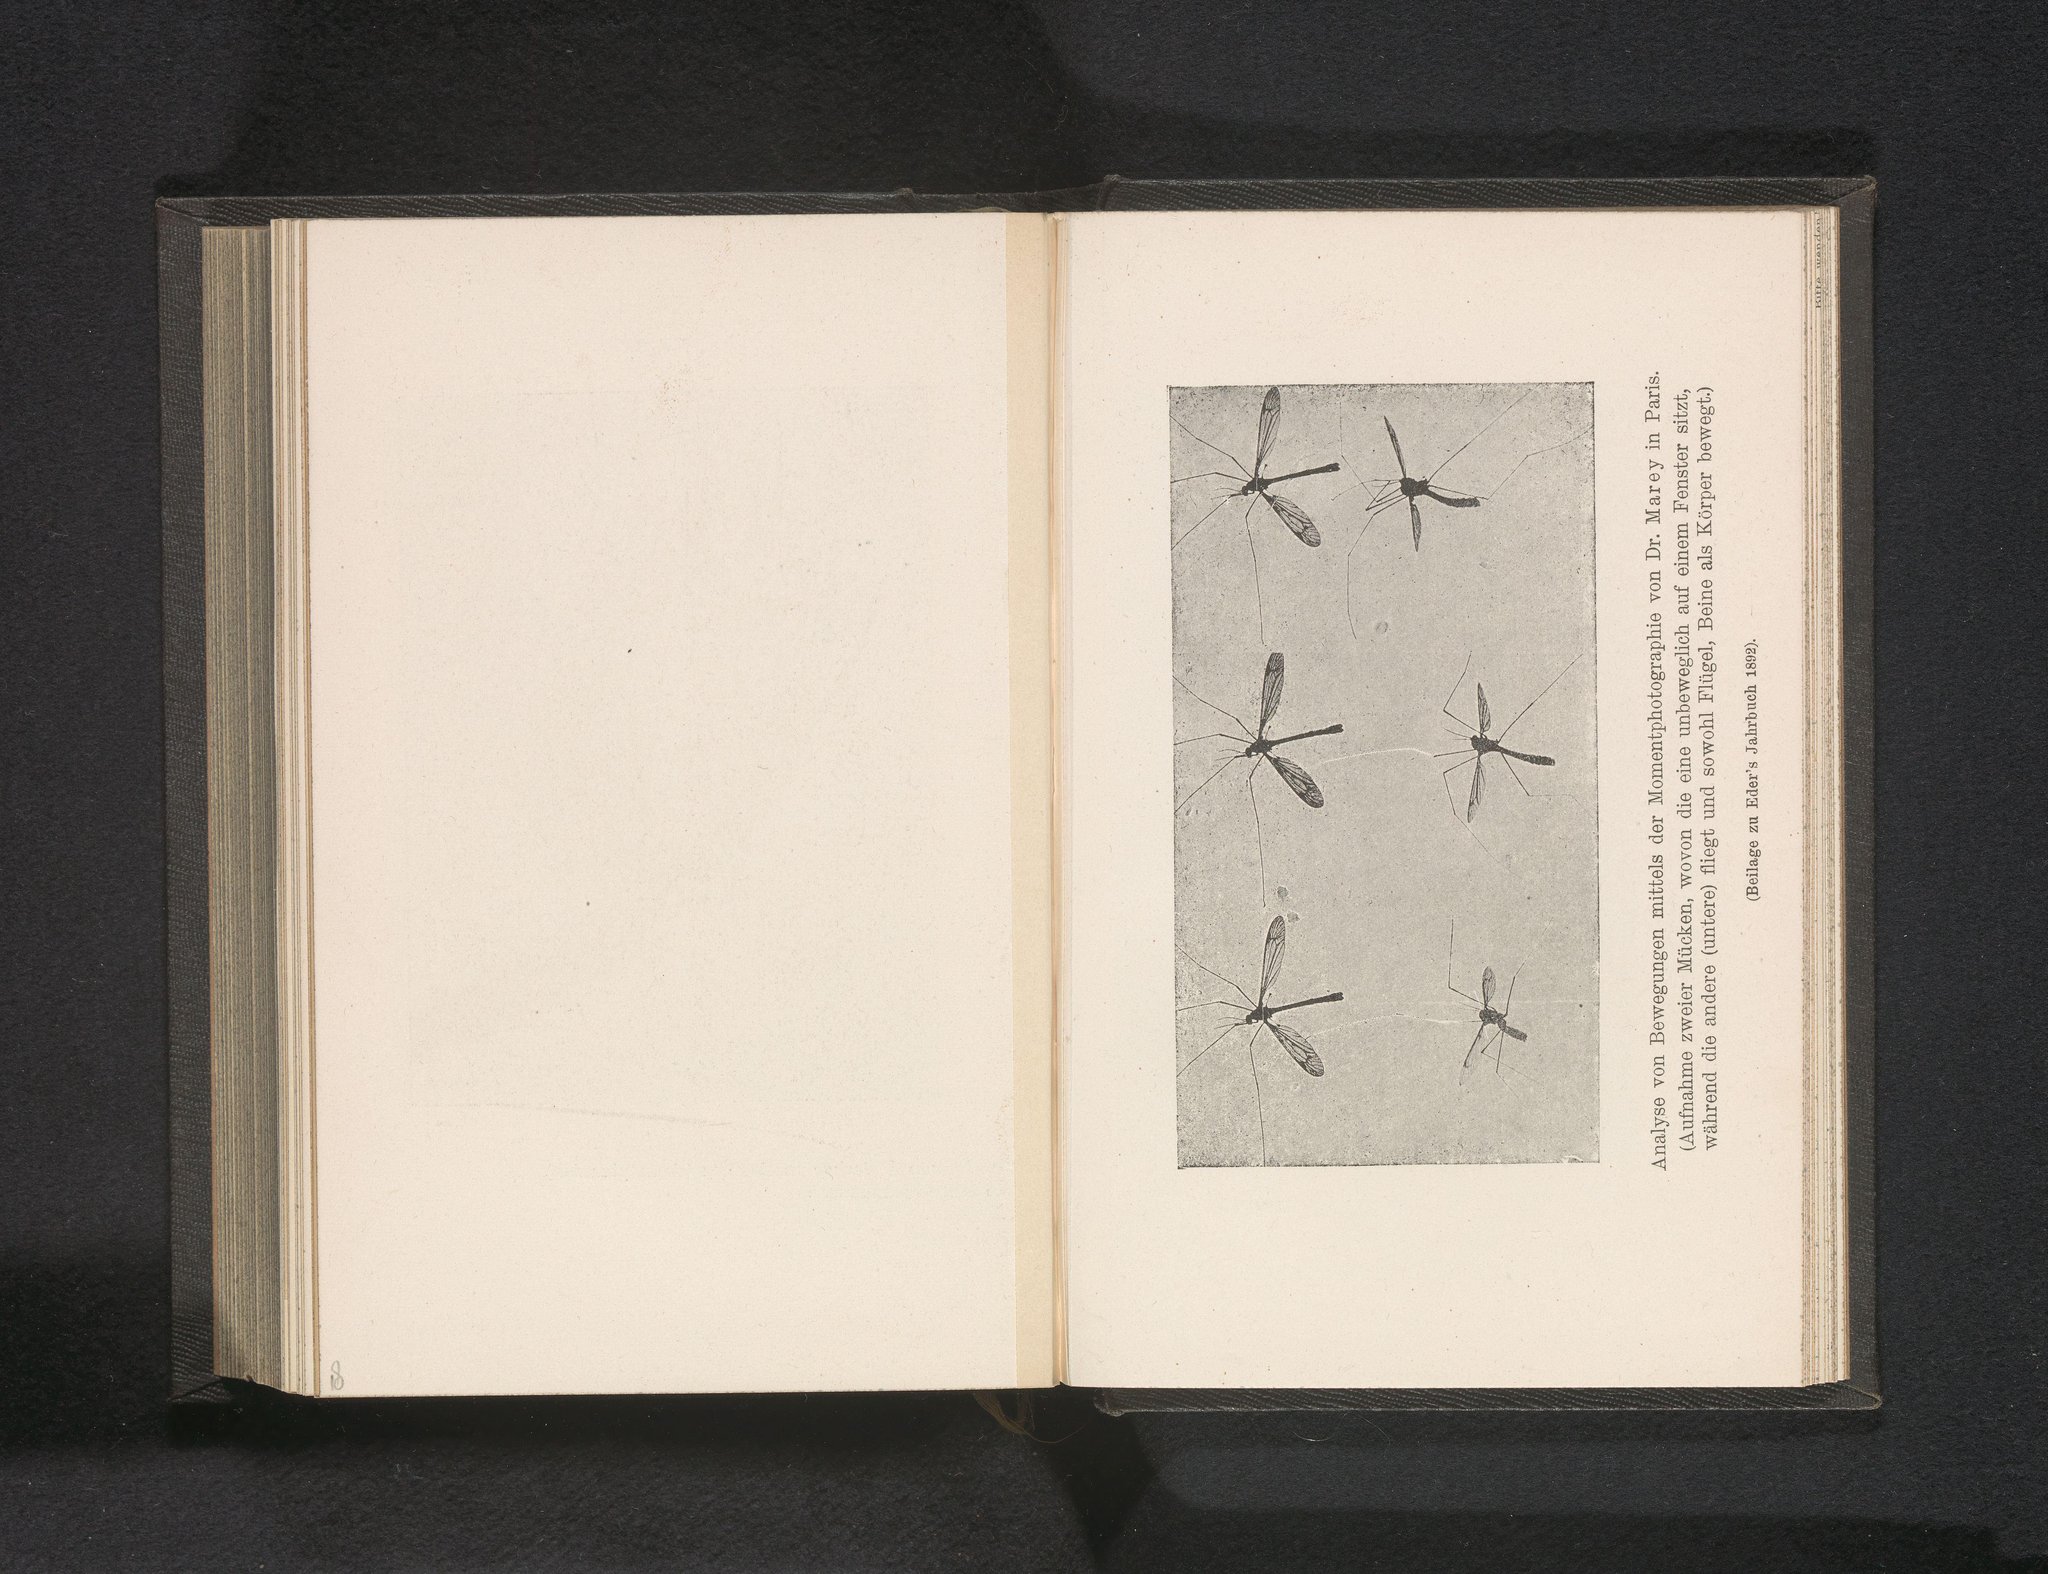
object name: page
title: Zes voorbeelden van de beweging van een mug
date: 1887-1892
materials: paper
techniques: autotype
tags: insects: mosquito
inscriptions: inscription: ‘Analyse von Bewegungen mittels der Momentphotographie von Dr. Marey in Paris (...)’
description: Prent op zevenendertigste ongenummerde pagina na pagina 520.